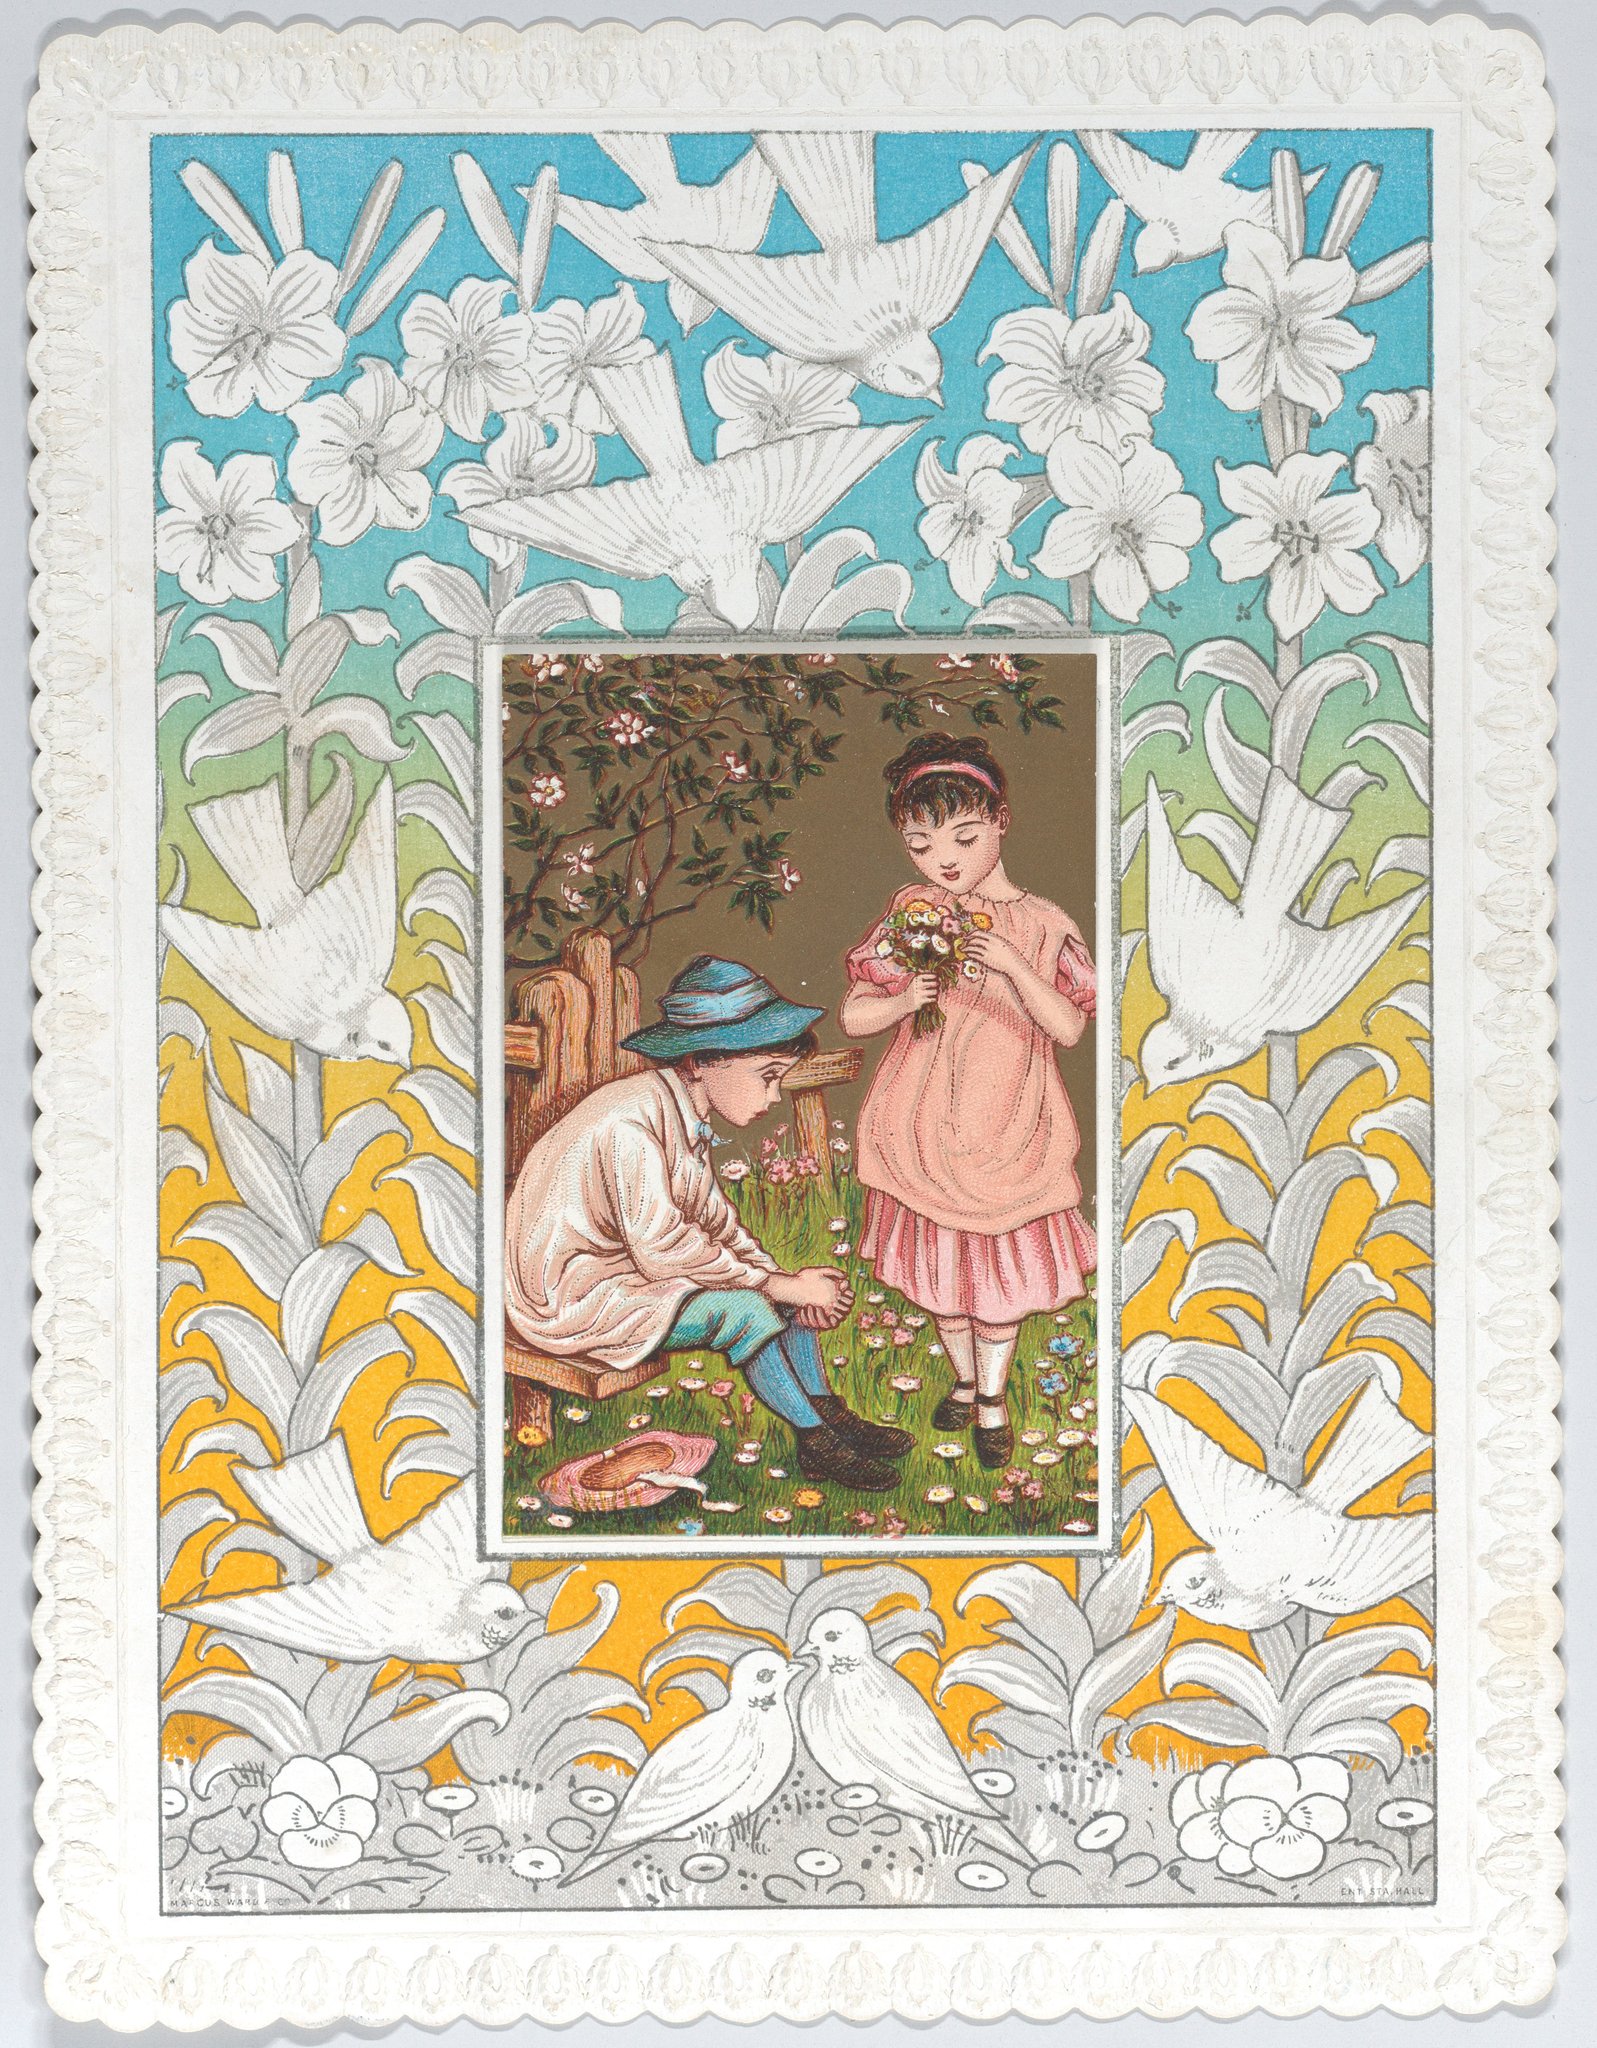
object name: valentine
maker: kate greenaway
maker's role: artist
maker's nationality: british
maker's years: 1846-1901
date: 1876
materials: gold, ink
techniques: chromolithography, embossing, gilding, lithograph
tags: doves,boys,girls